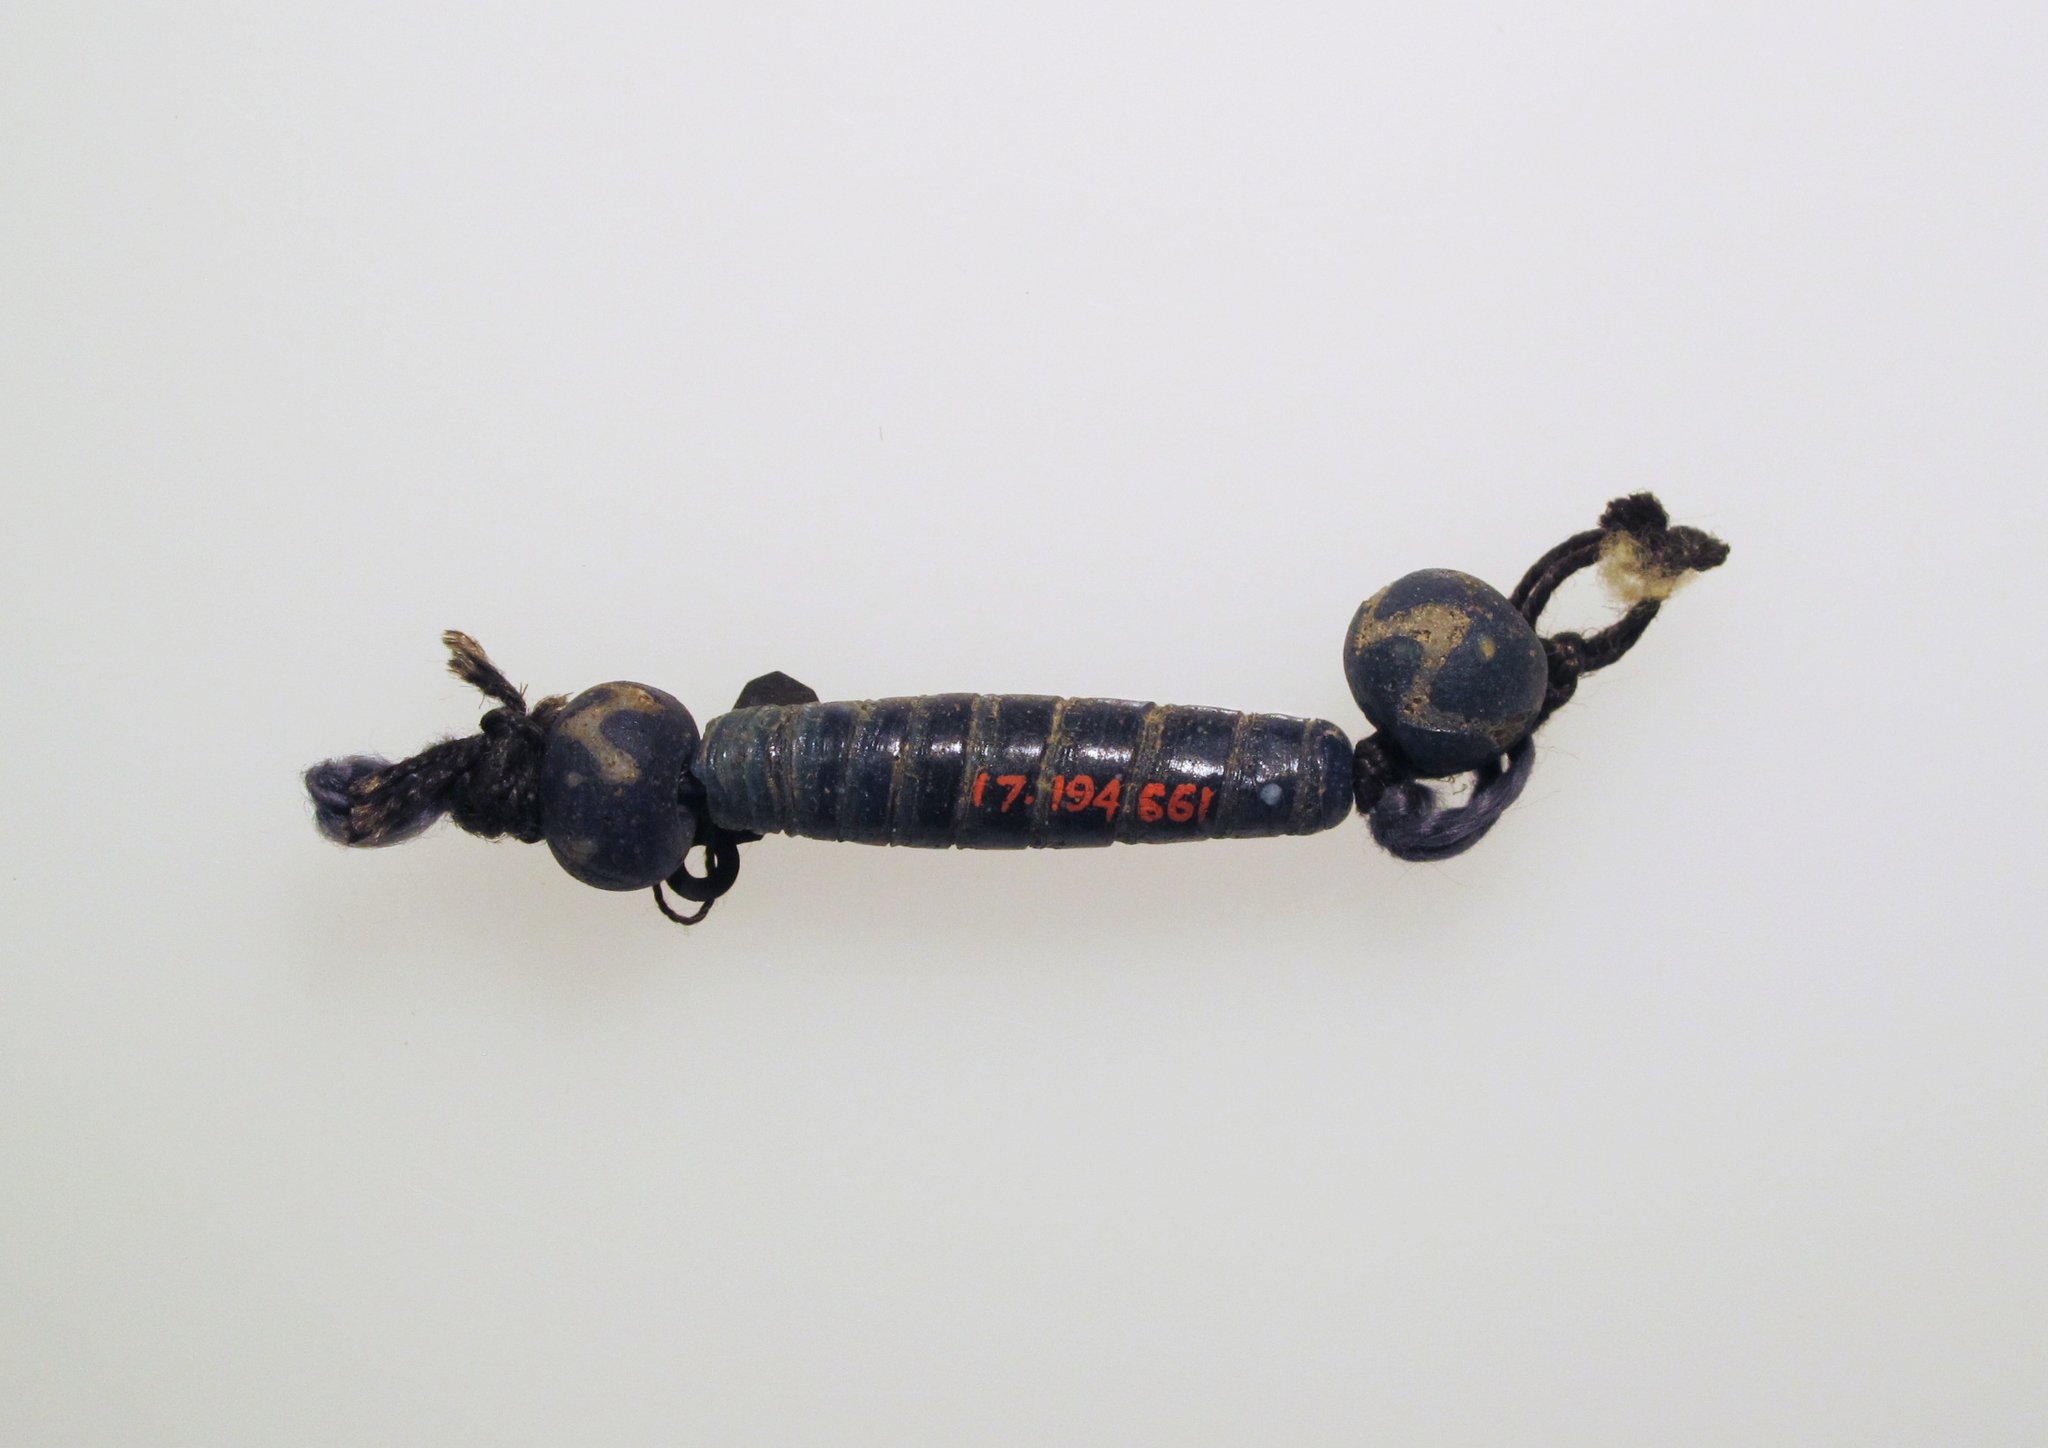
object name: bead, 3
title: Beads, 3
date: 7000 BCE-330 CE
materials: glass